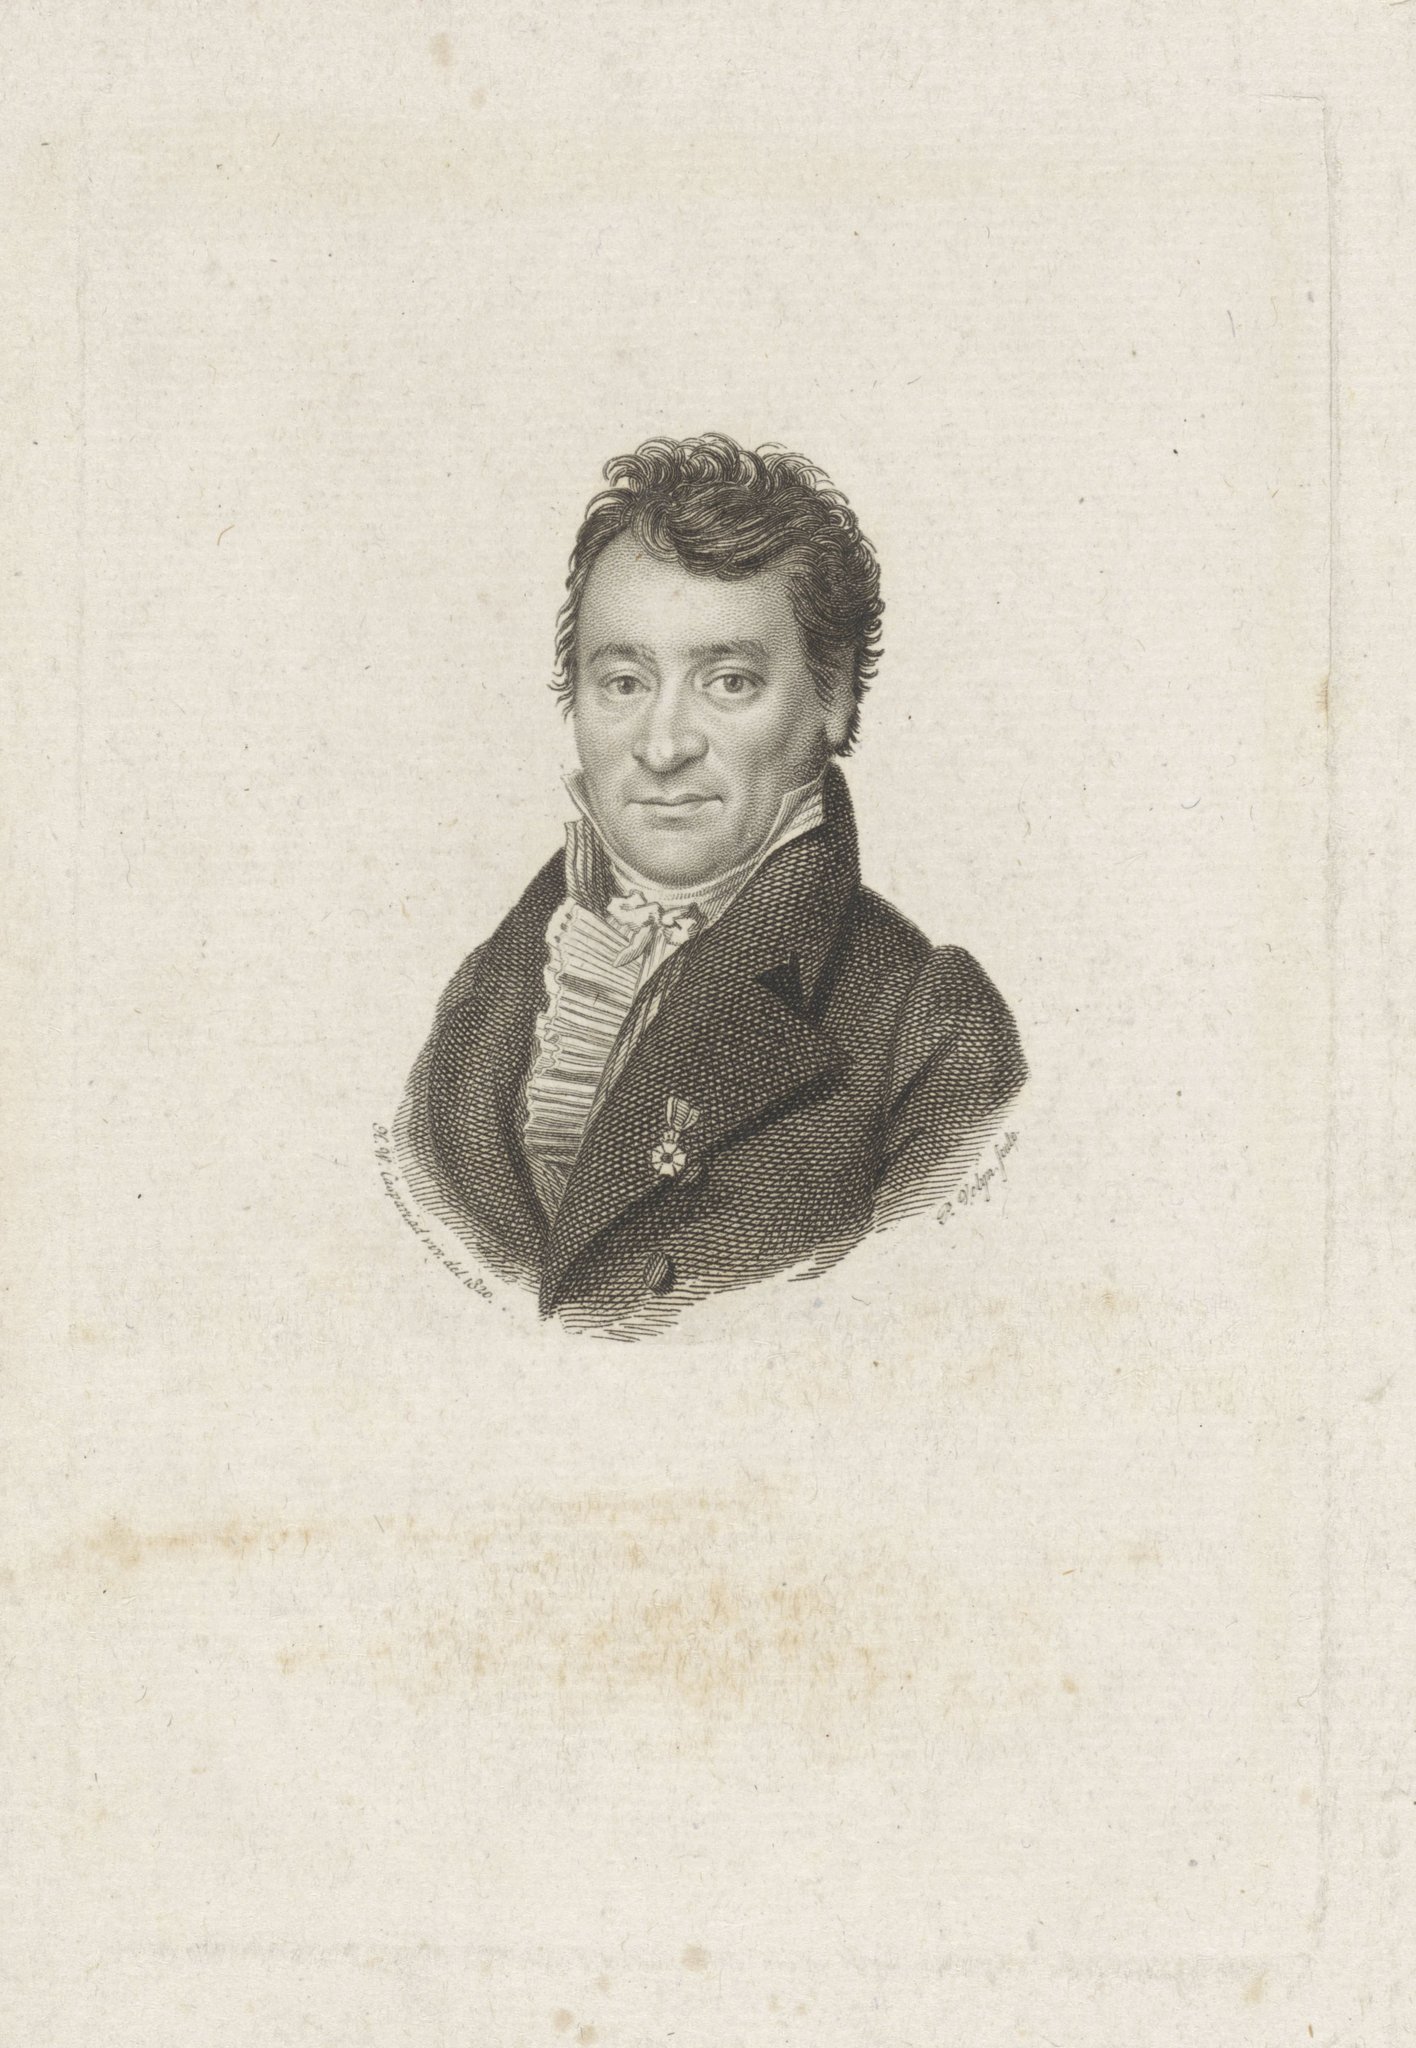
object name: print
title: Portret van de dichter Hendrik Tollens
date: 1821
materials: paper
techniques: engraving, etching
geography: netherlands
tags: rotterdam, hendrik tollens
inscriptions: collector's mark: Lugt 2228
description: Latere staat prent volgens Van Someren ook gebruikt in: Nederlandsche Muzen-Almanak. Rotterdam: J. Immerzeel, 1821.